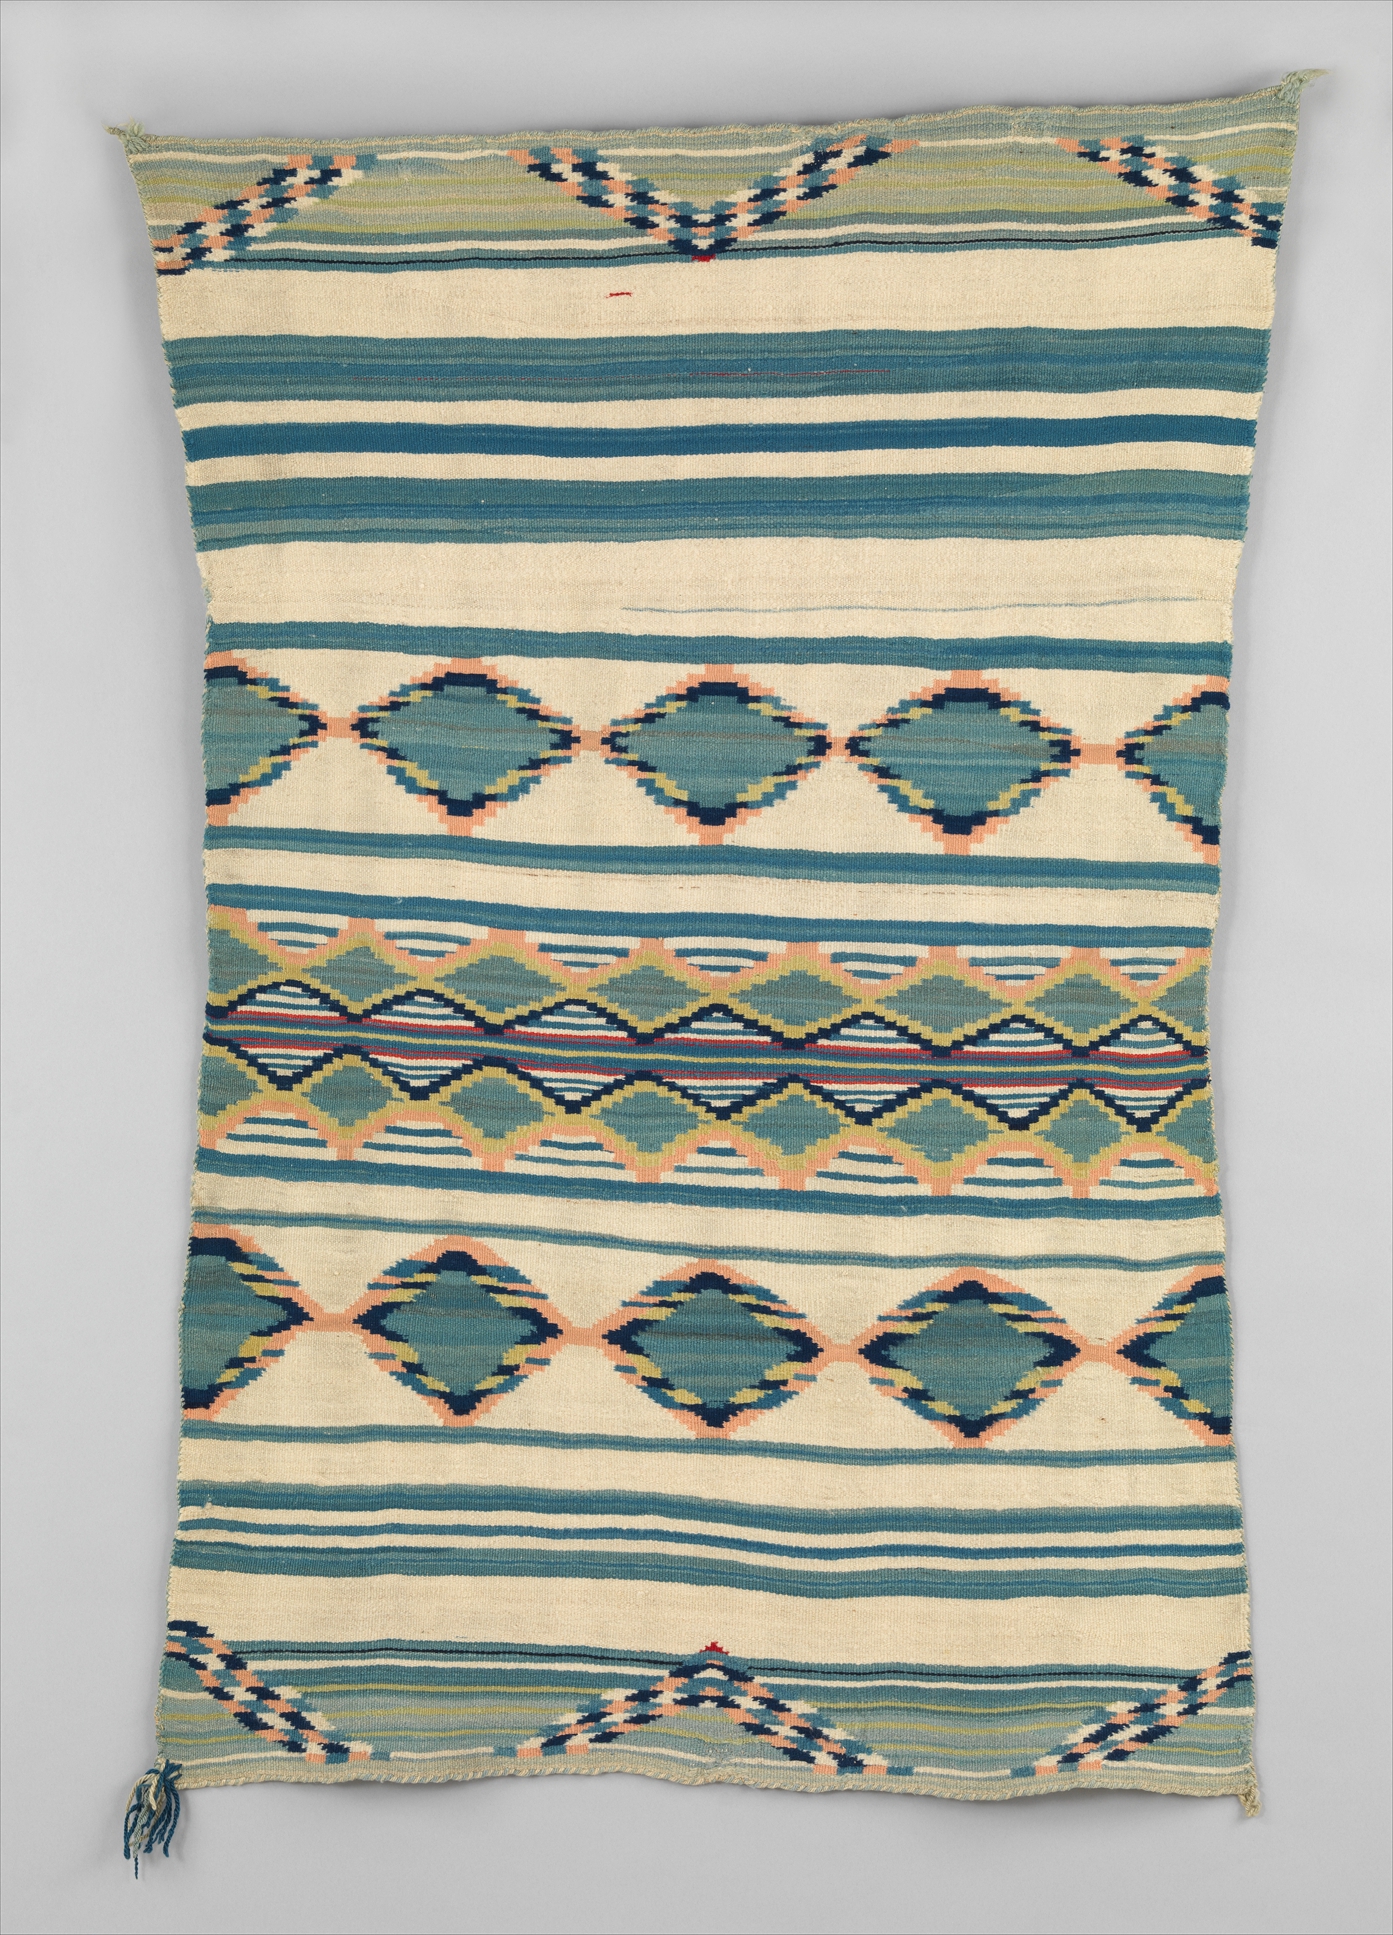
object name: blanket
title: Saddle Blanket (?)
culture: navajo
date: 1860-1870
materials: wool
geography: united states